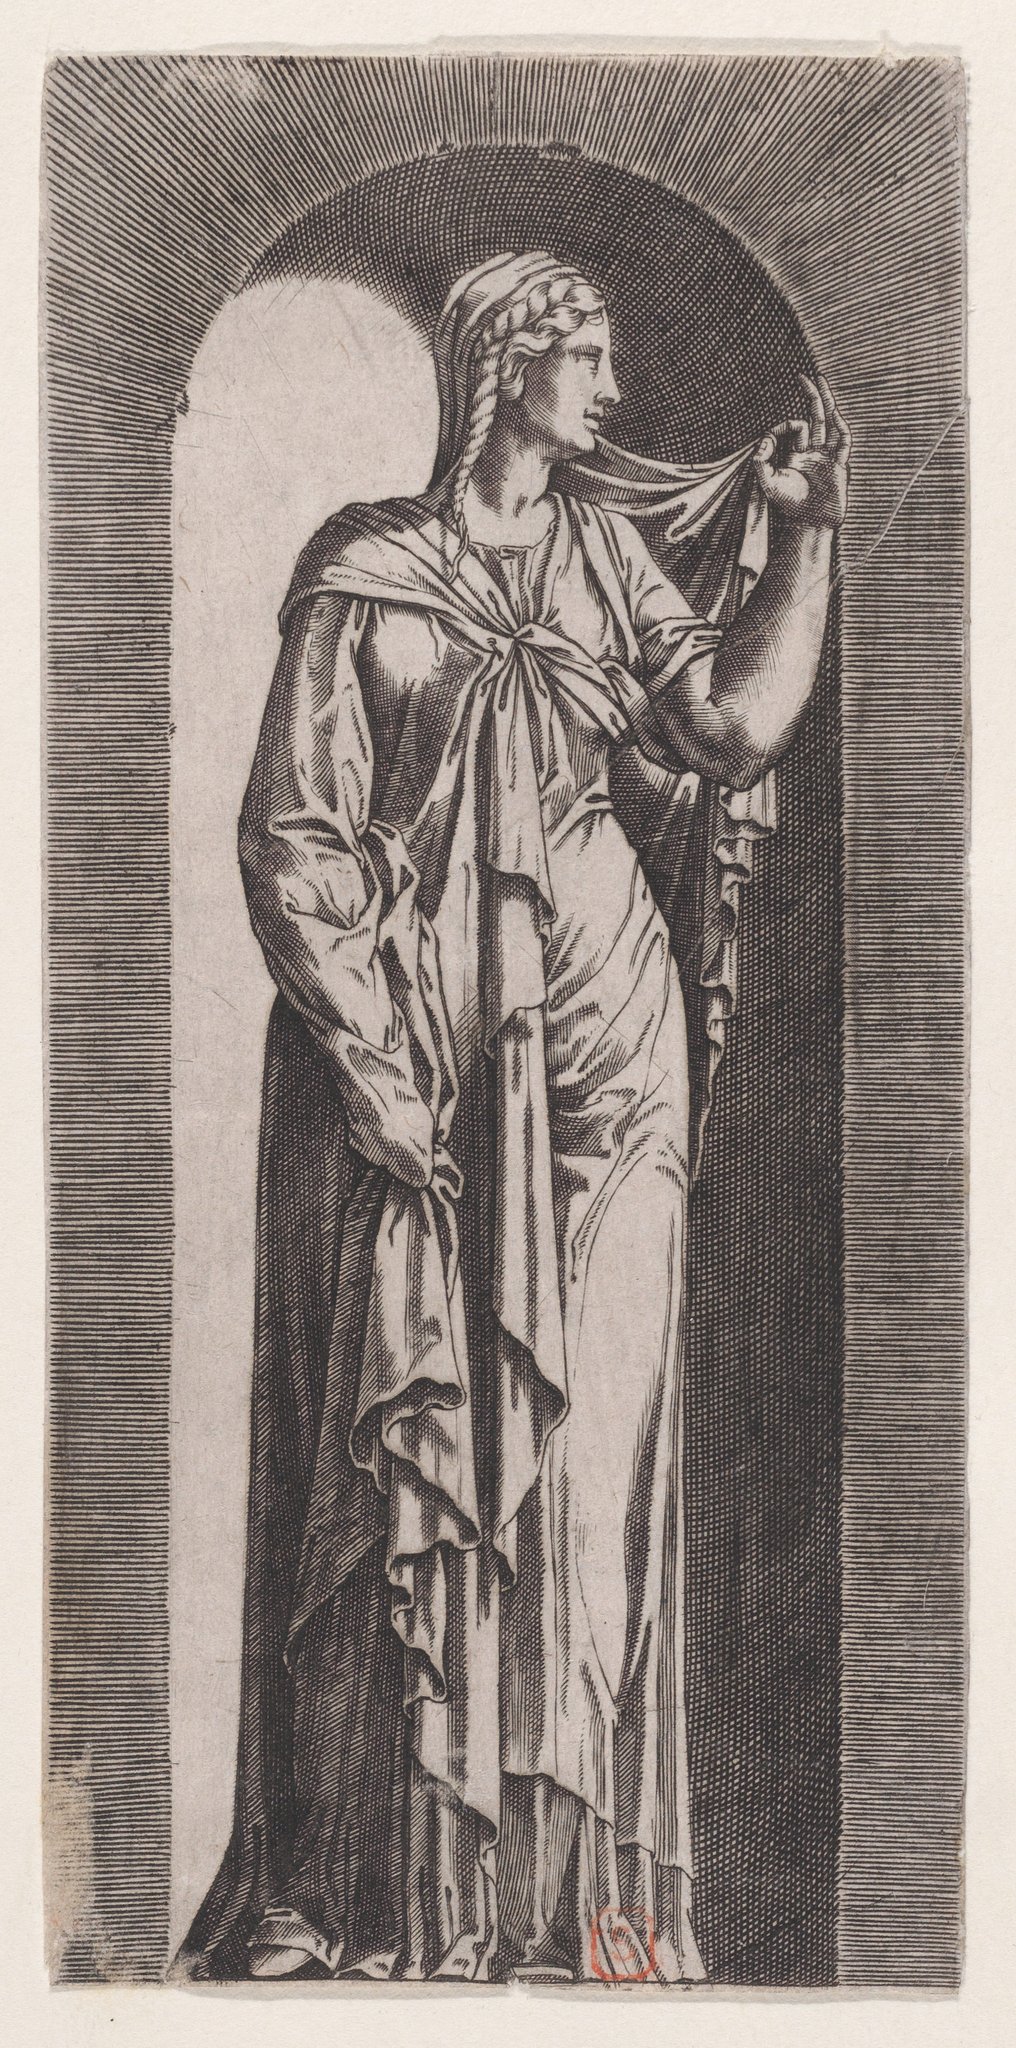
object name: print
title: Sibyl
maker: lambert suavius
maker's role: artist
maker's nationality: netherlandish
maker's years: 1510-1576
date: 1530-1576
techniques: engraving